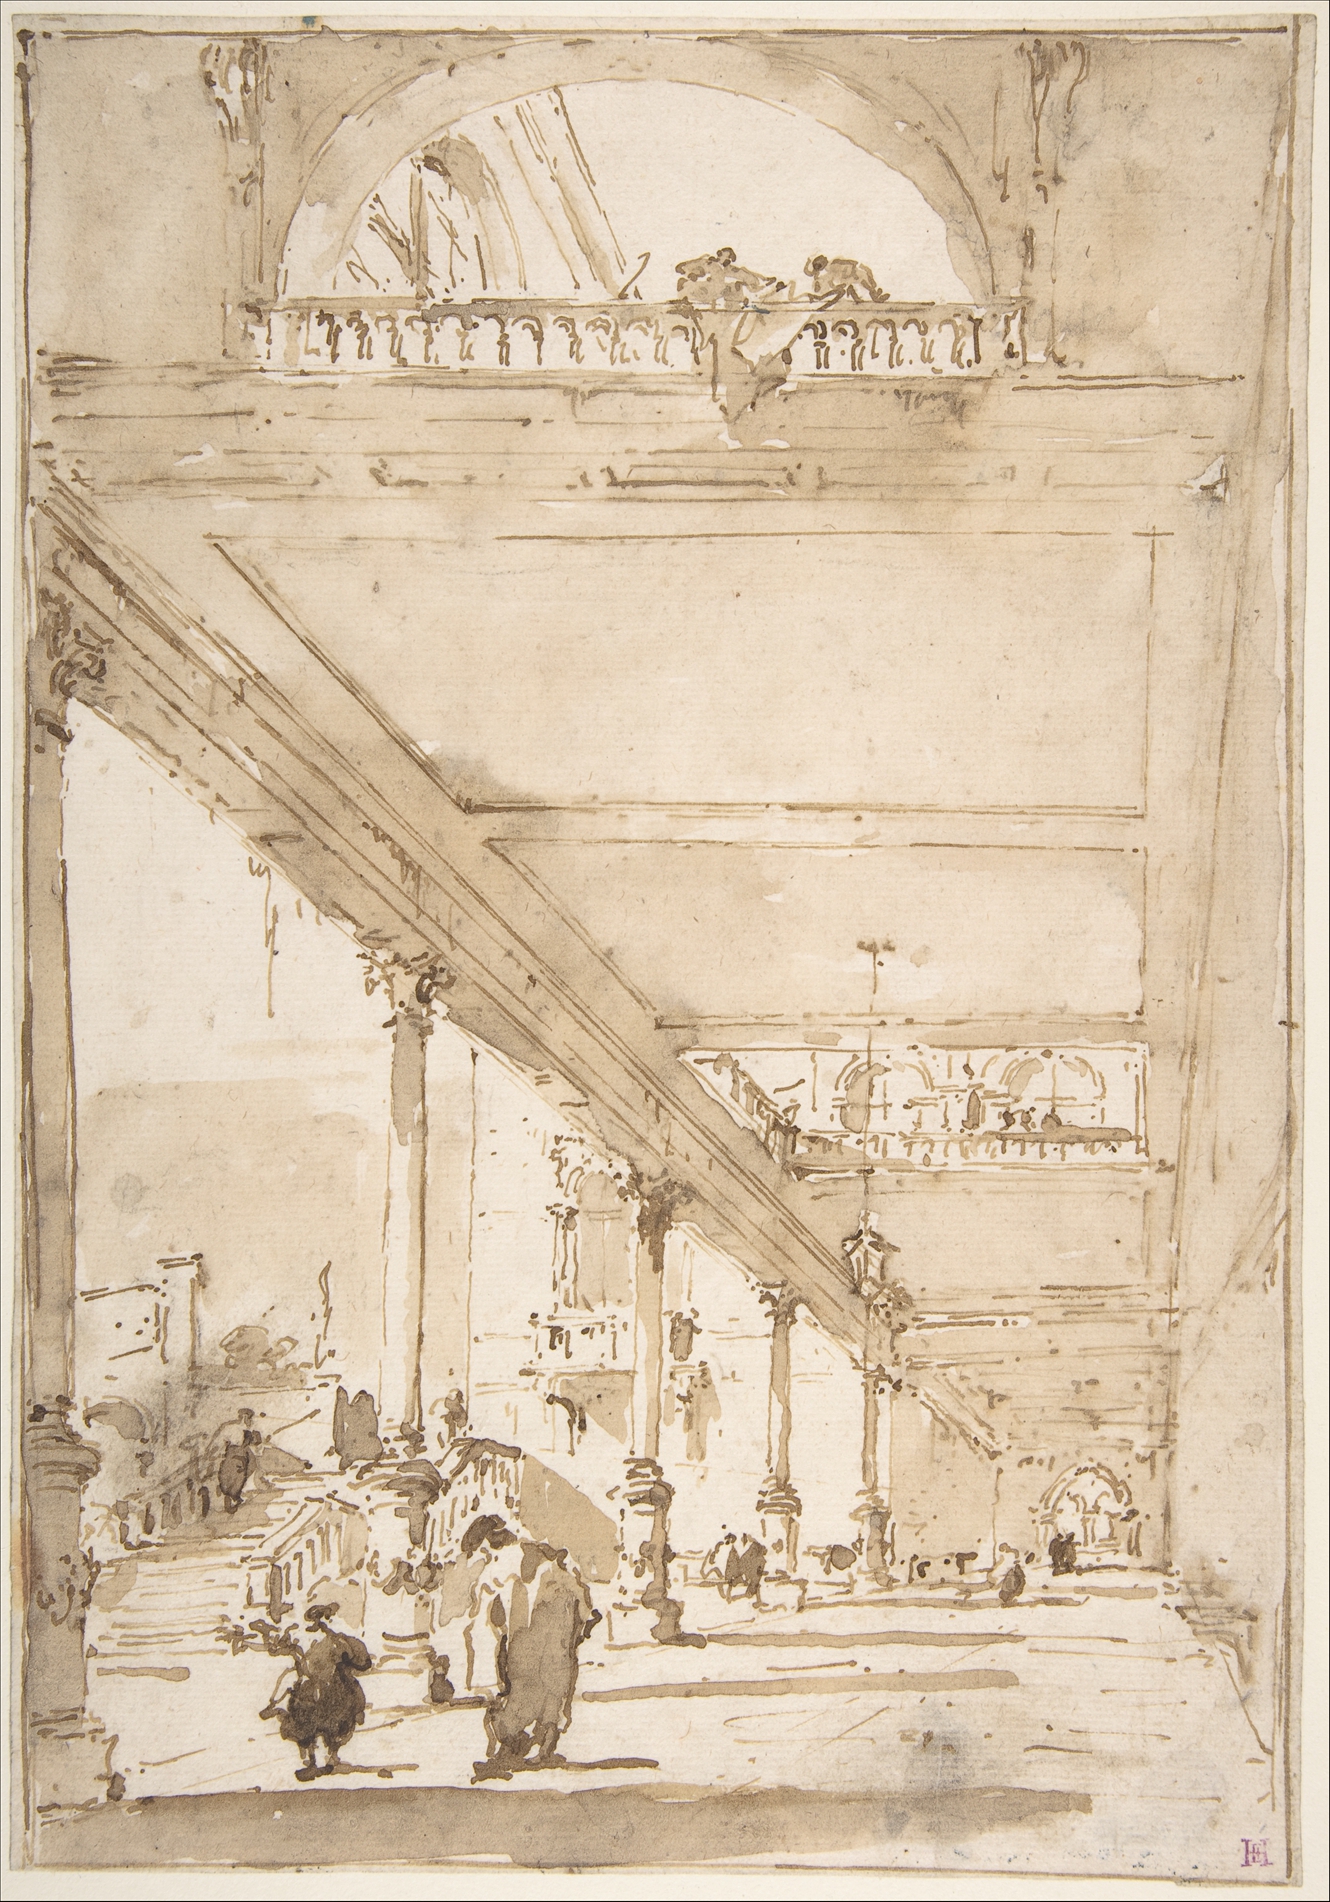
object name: drawing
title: Architectural Capriccio: A Palace Colonnade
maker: francesco guardi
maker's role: artist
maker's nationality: italian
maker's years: 1712-1793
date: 1712-1793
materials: chalk, ink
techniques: brush, pen, wash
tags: architecture